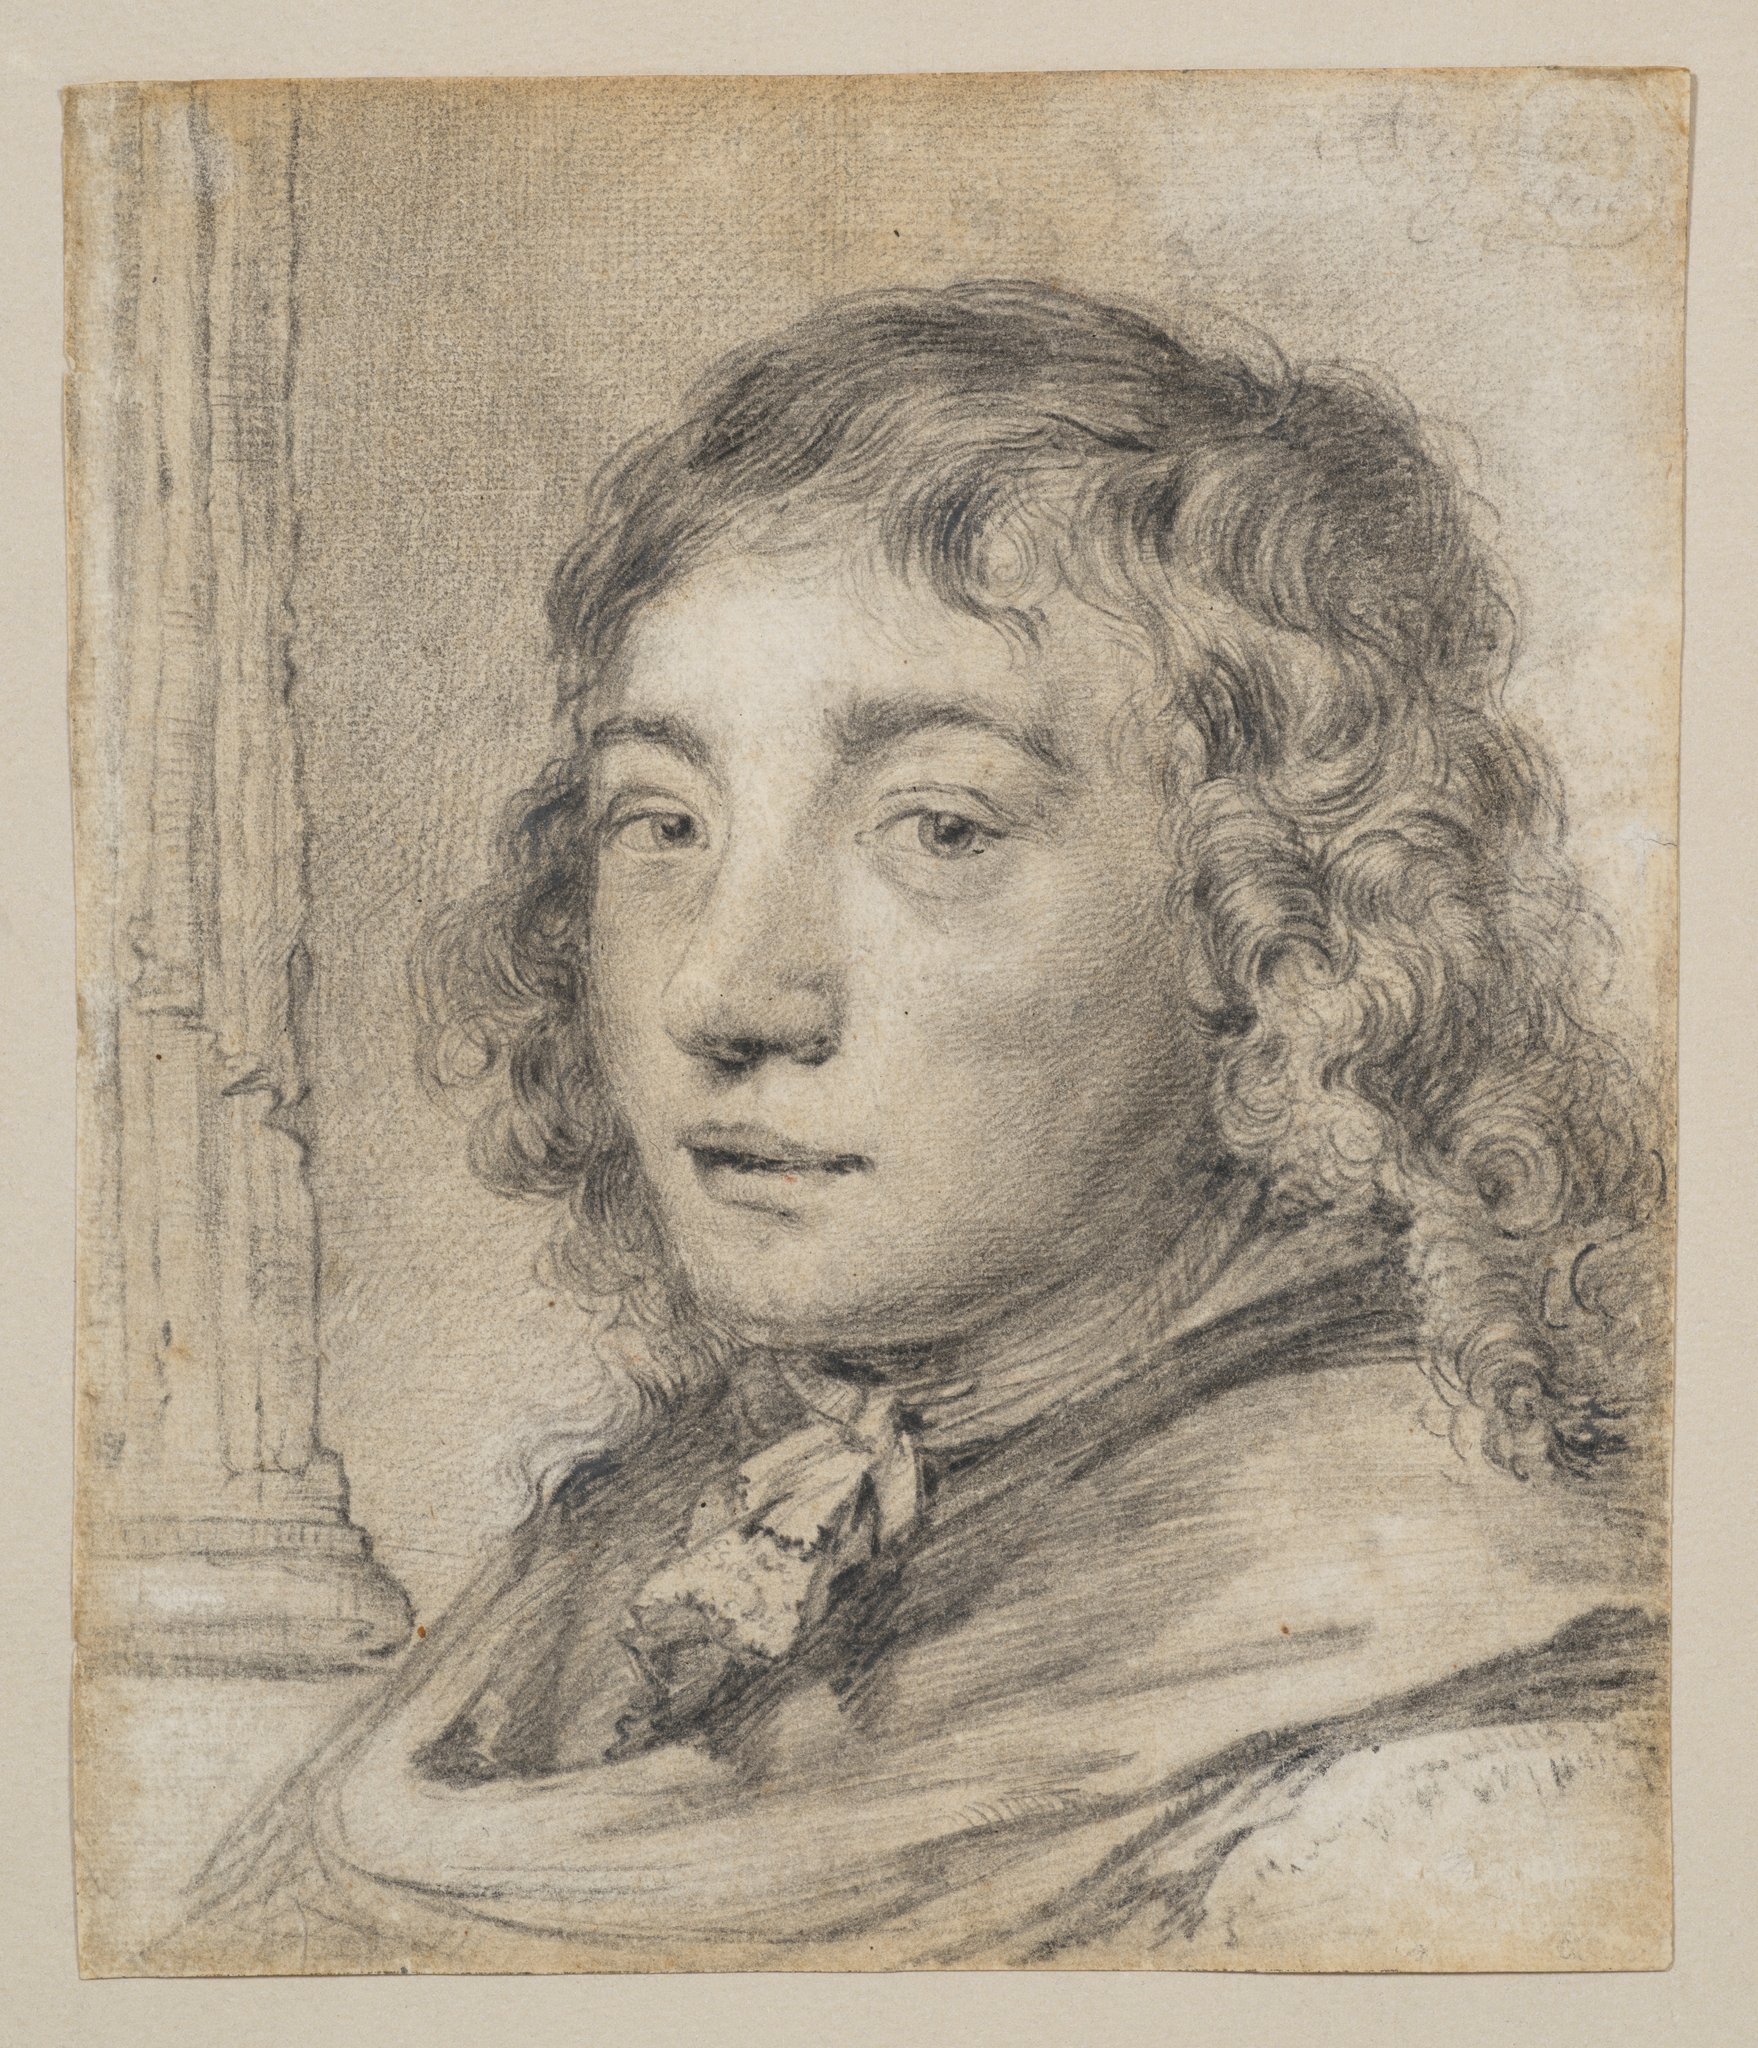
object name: drawing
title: Portrait of a Young Man (probably a self-portrait)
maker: cornelis visscher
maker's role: artist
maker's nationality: dutch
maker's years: 1628-1658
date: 1650-1651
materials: chalk, paper